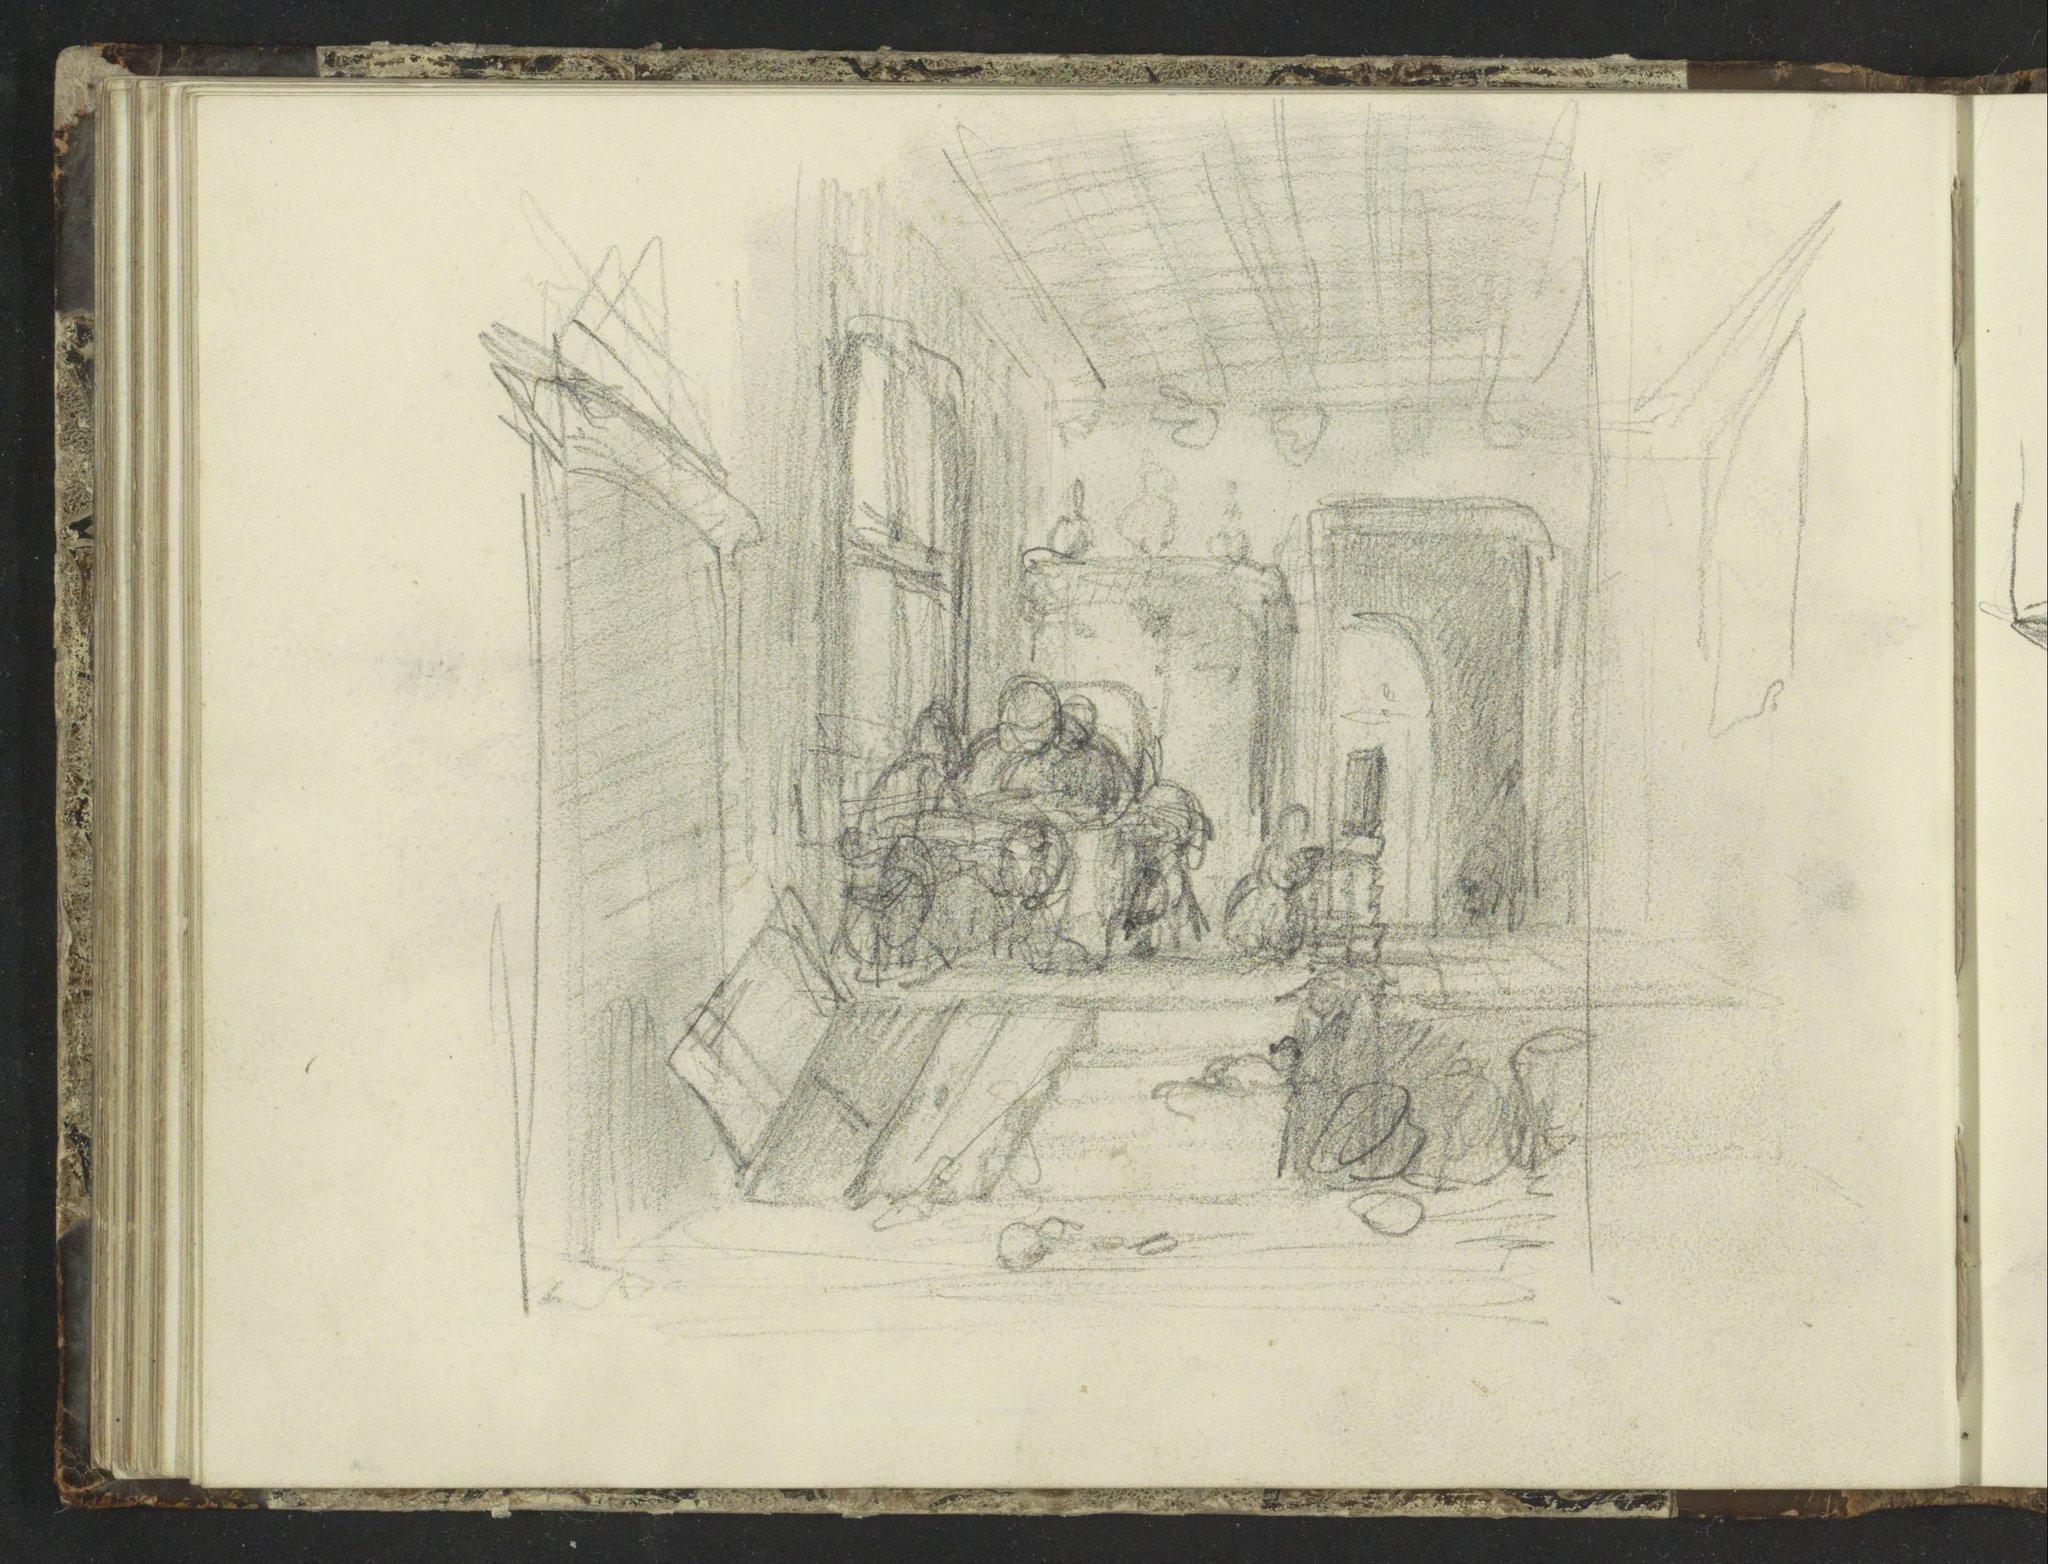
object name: sketchbook leaf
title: Interieur met een zittende figuur bij een venster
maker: willem hendrik schmidt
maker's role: draughtsman, painter, print maker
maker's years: 1809-1849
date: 1819-1849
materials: paper, pencil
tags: sitting figure, window, interior of the house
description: Tekening in een kader. Mogelijk een voorstudie voor een schilderij. Blad 27 verso uit een schetsboek met 58 bladen.